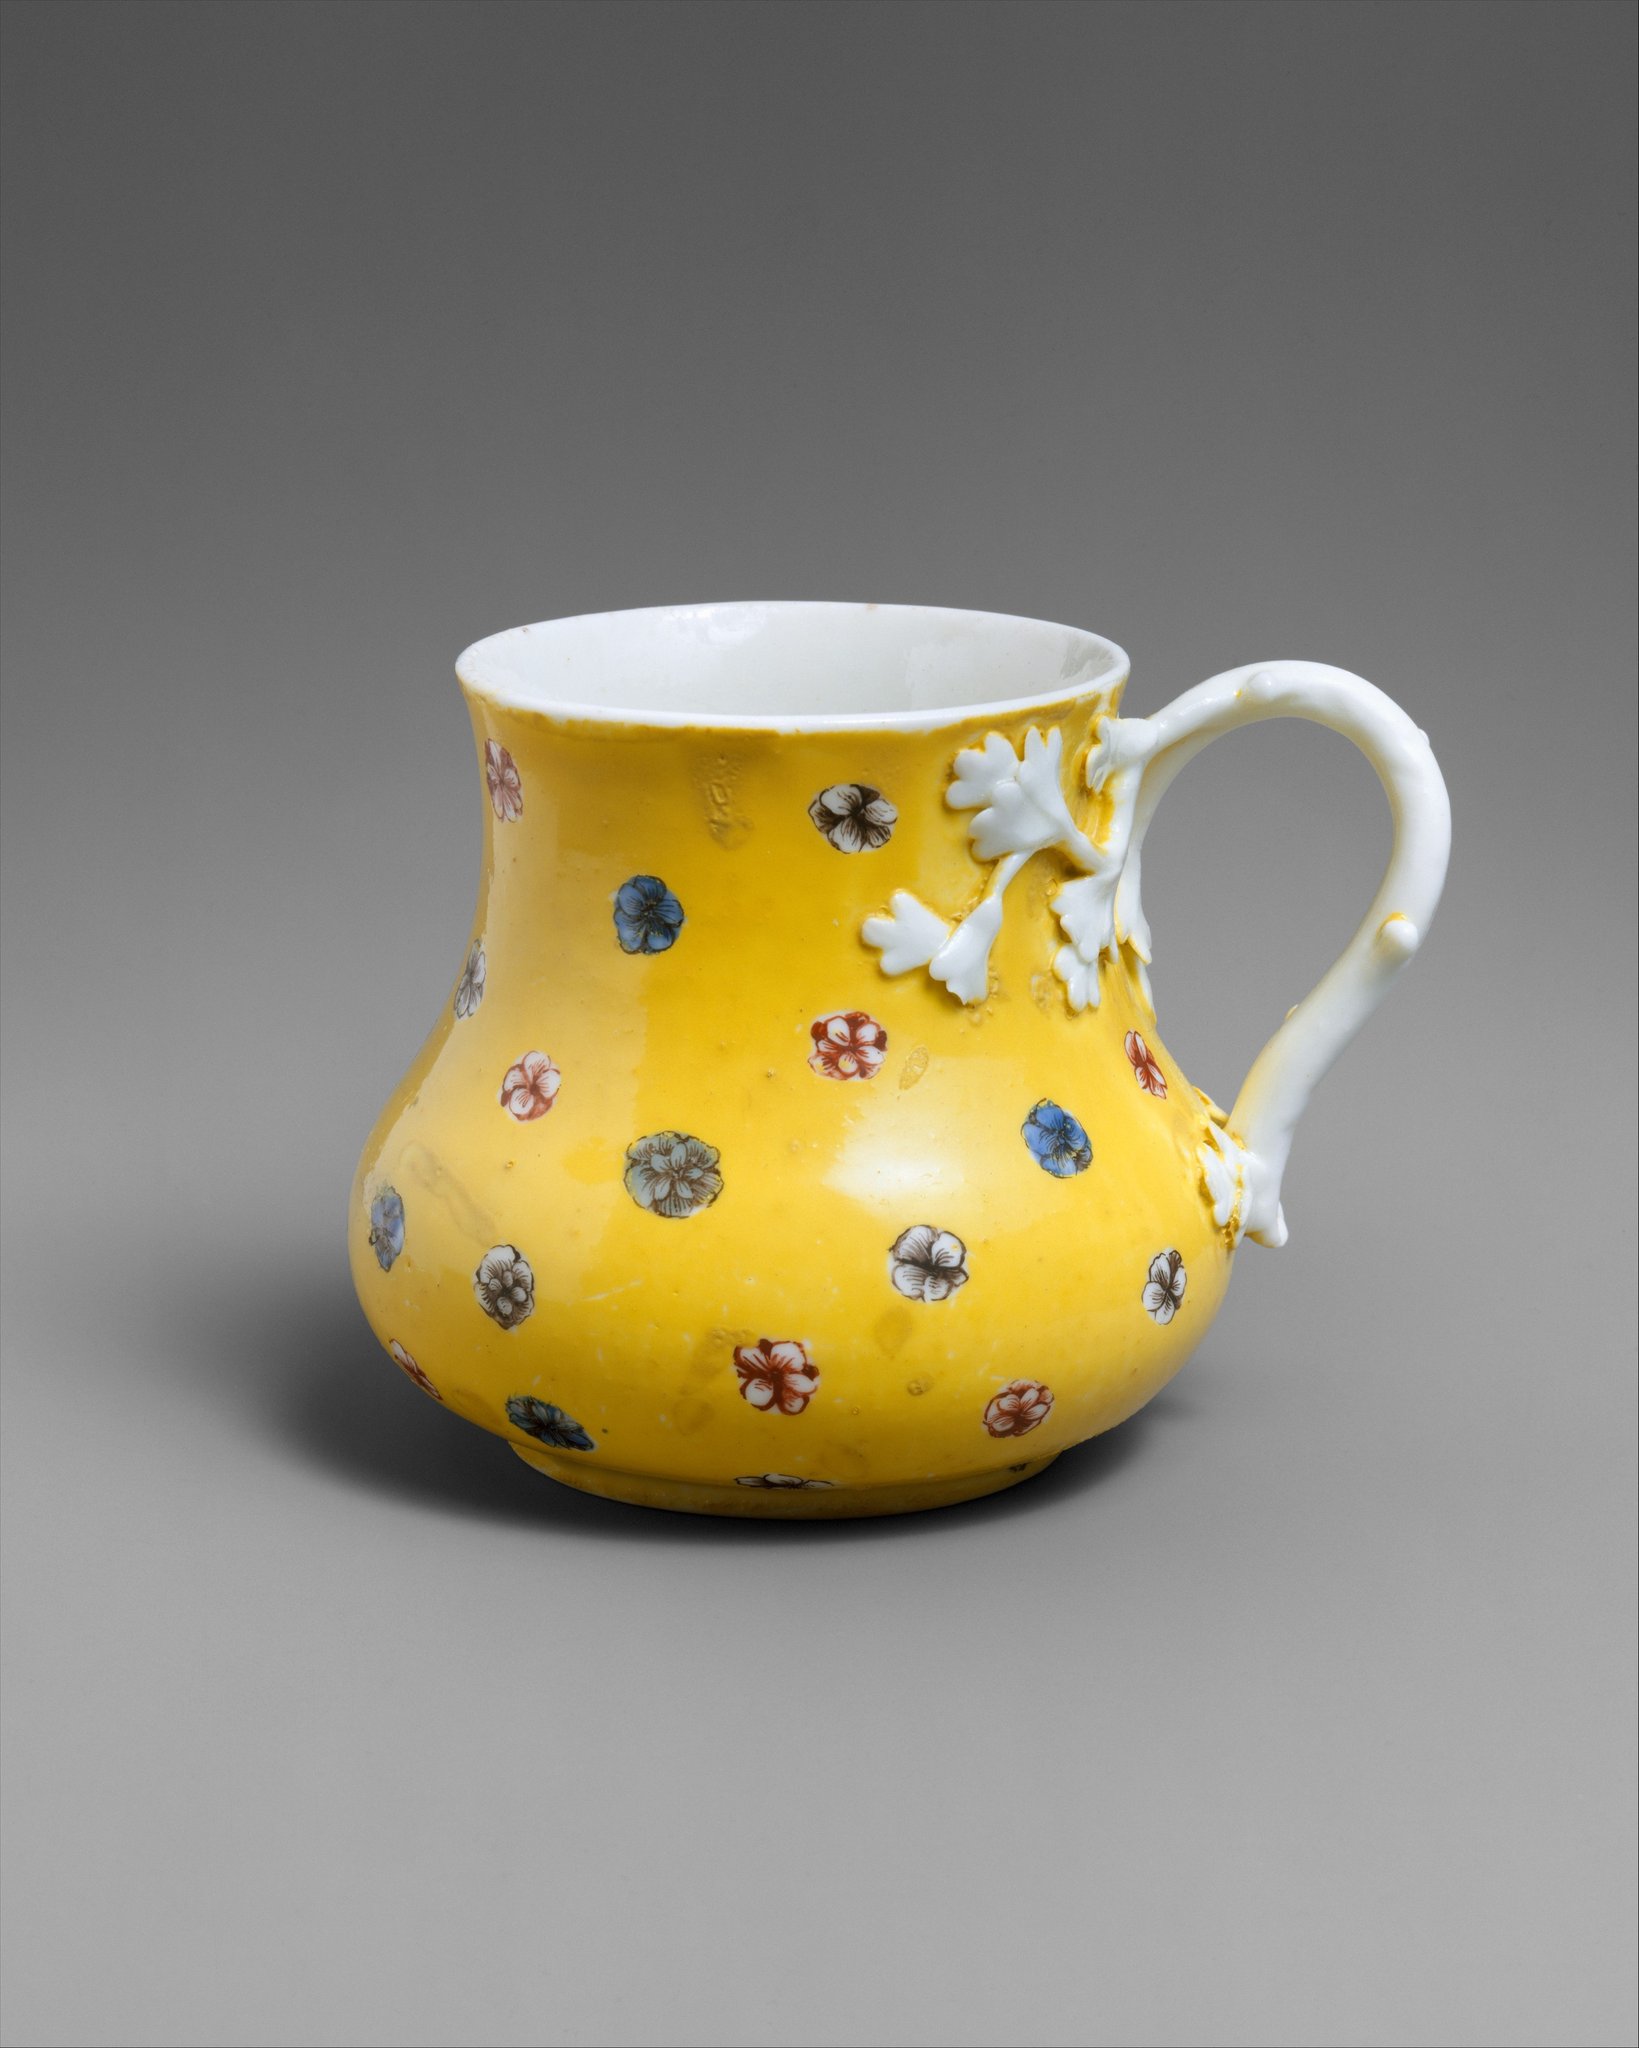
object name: mug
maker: saint-cloud factory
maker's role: manufactory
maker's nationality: french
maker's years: 1693-1766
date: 1730-1735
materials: soft paste porcelain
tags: flowers